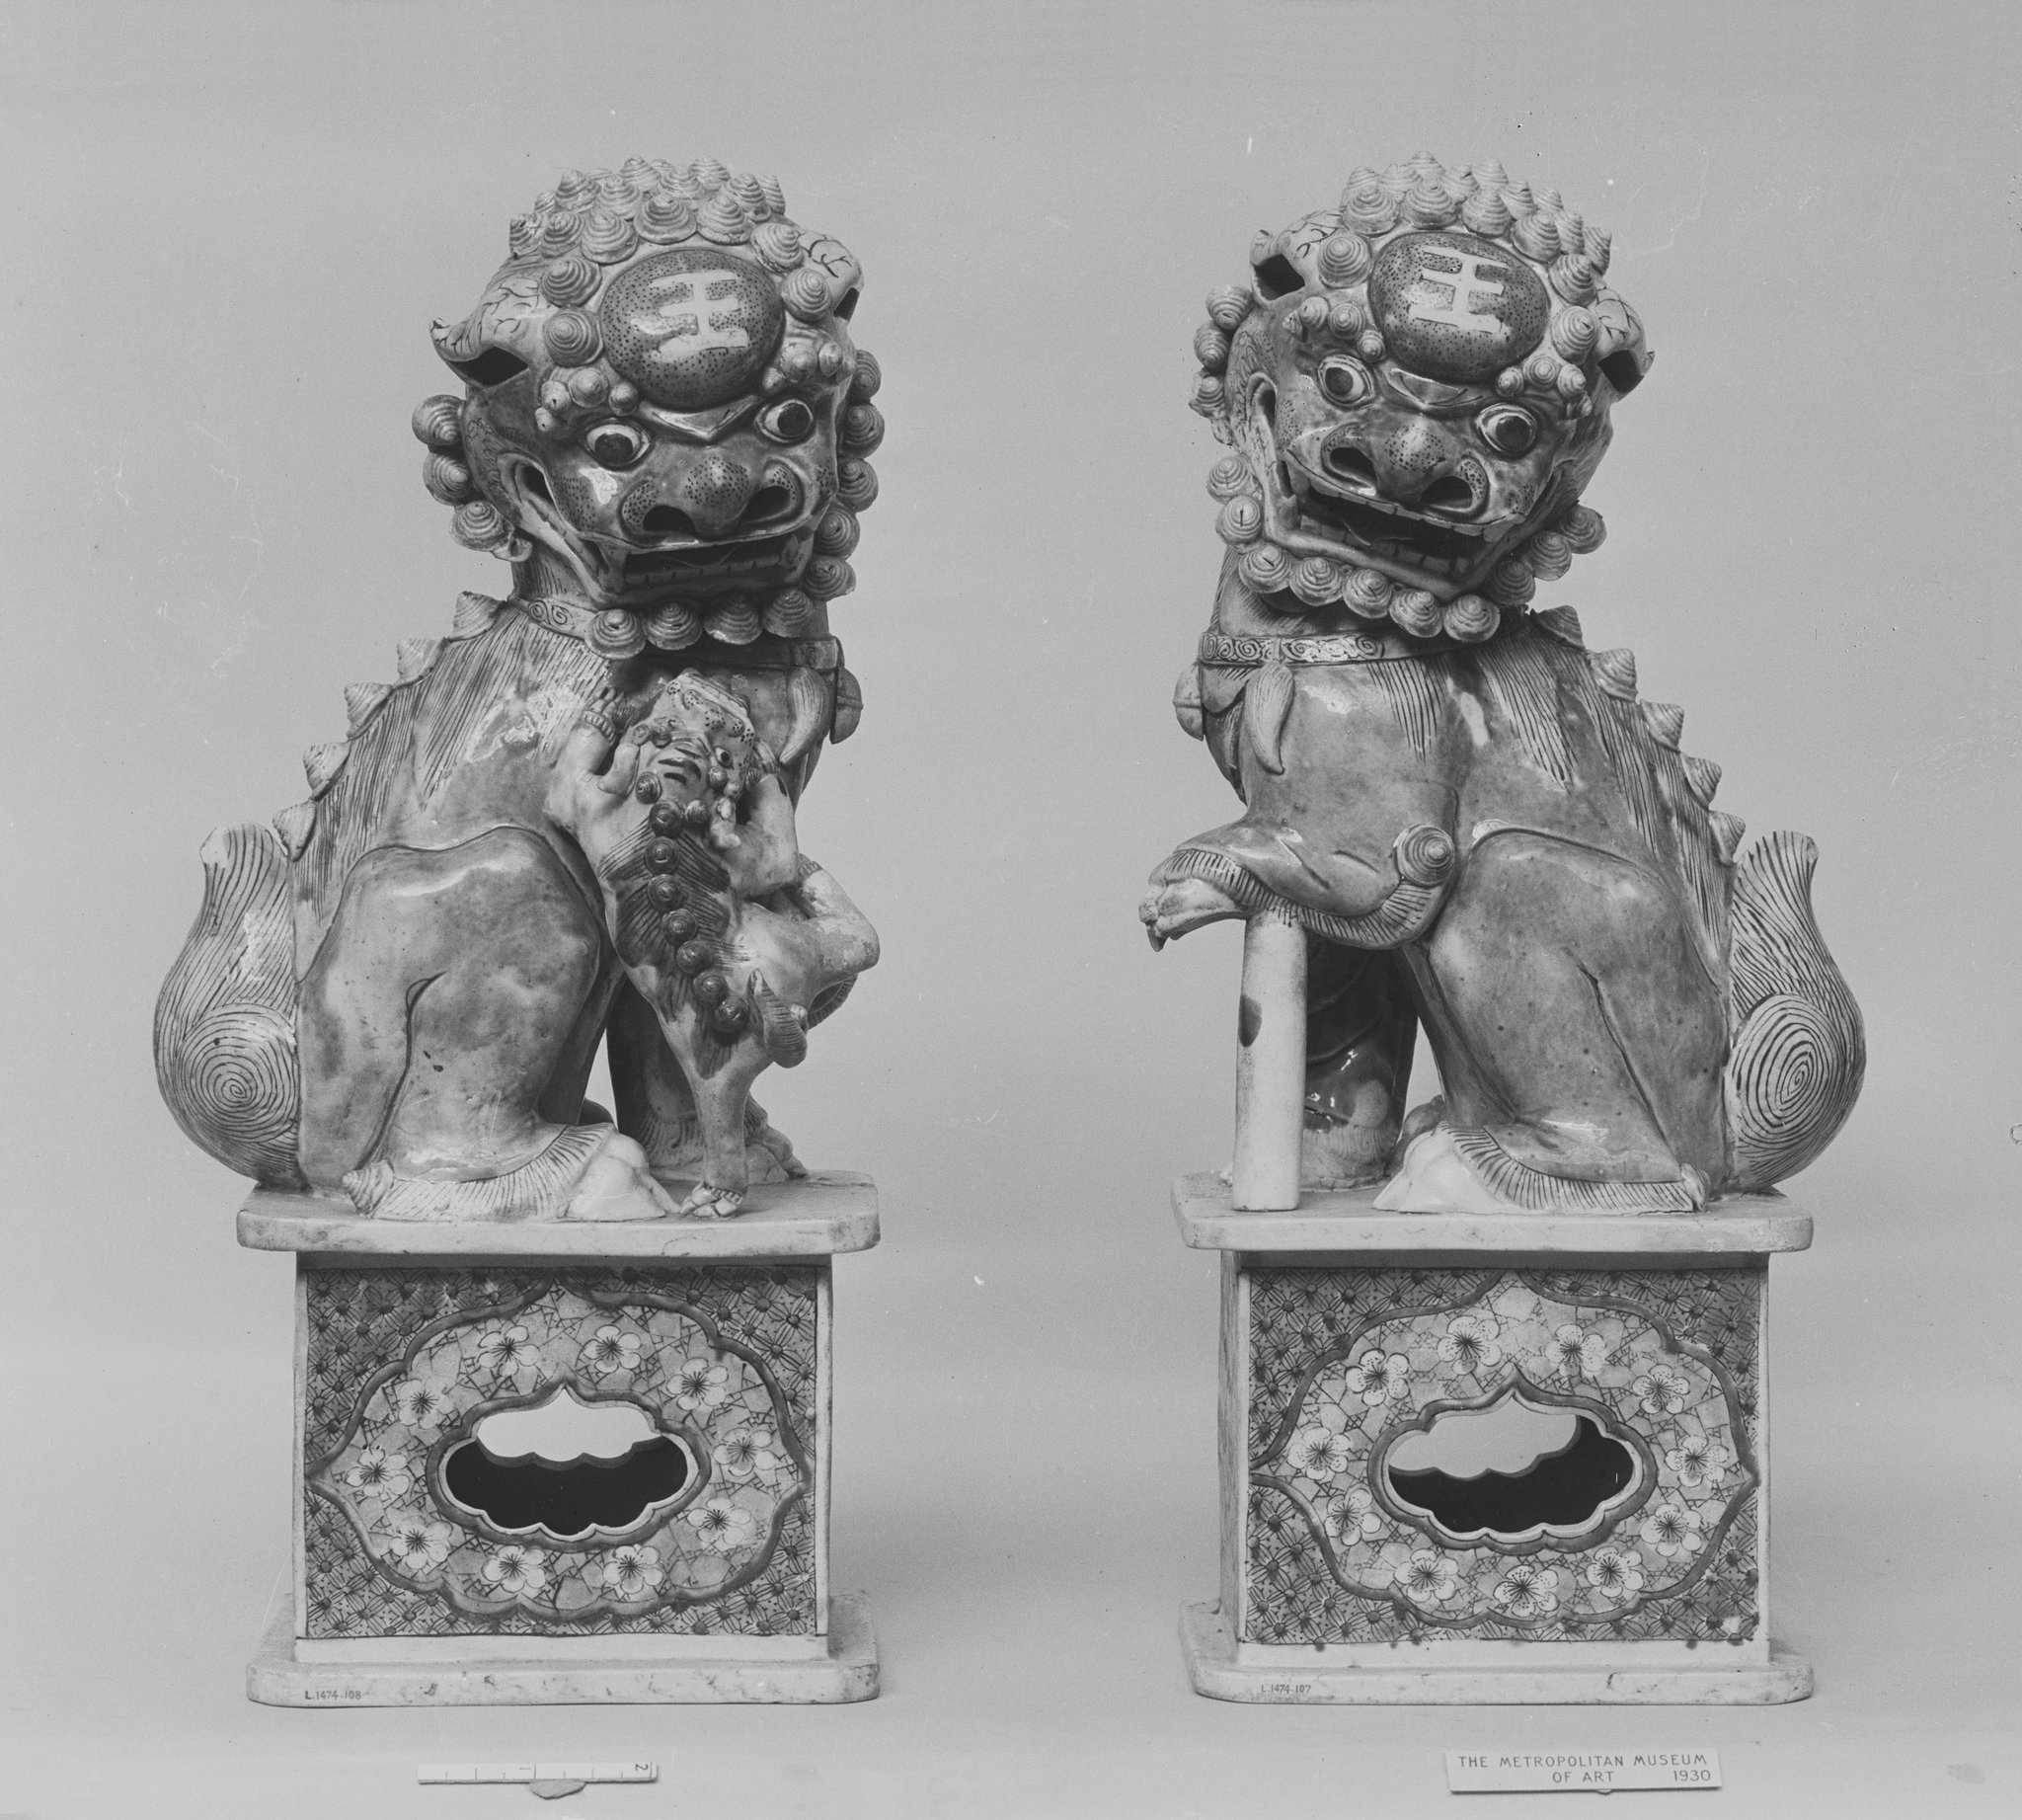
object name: figure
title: Figure of a Lion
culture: chinese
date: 1662-1722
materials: porcelain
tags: lions